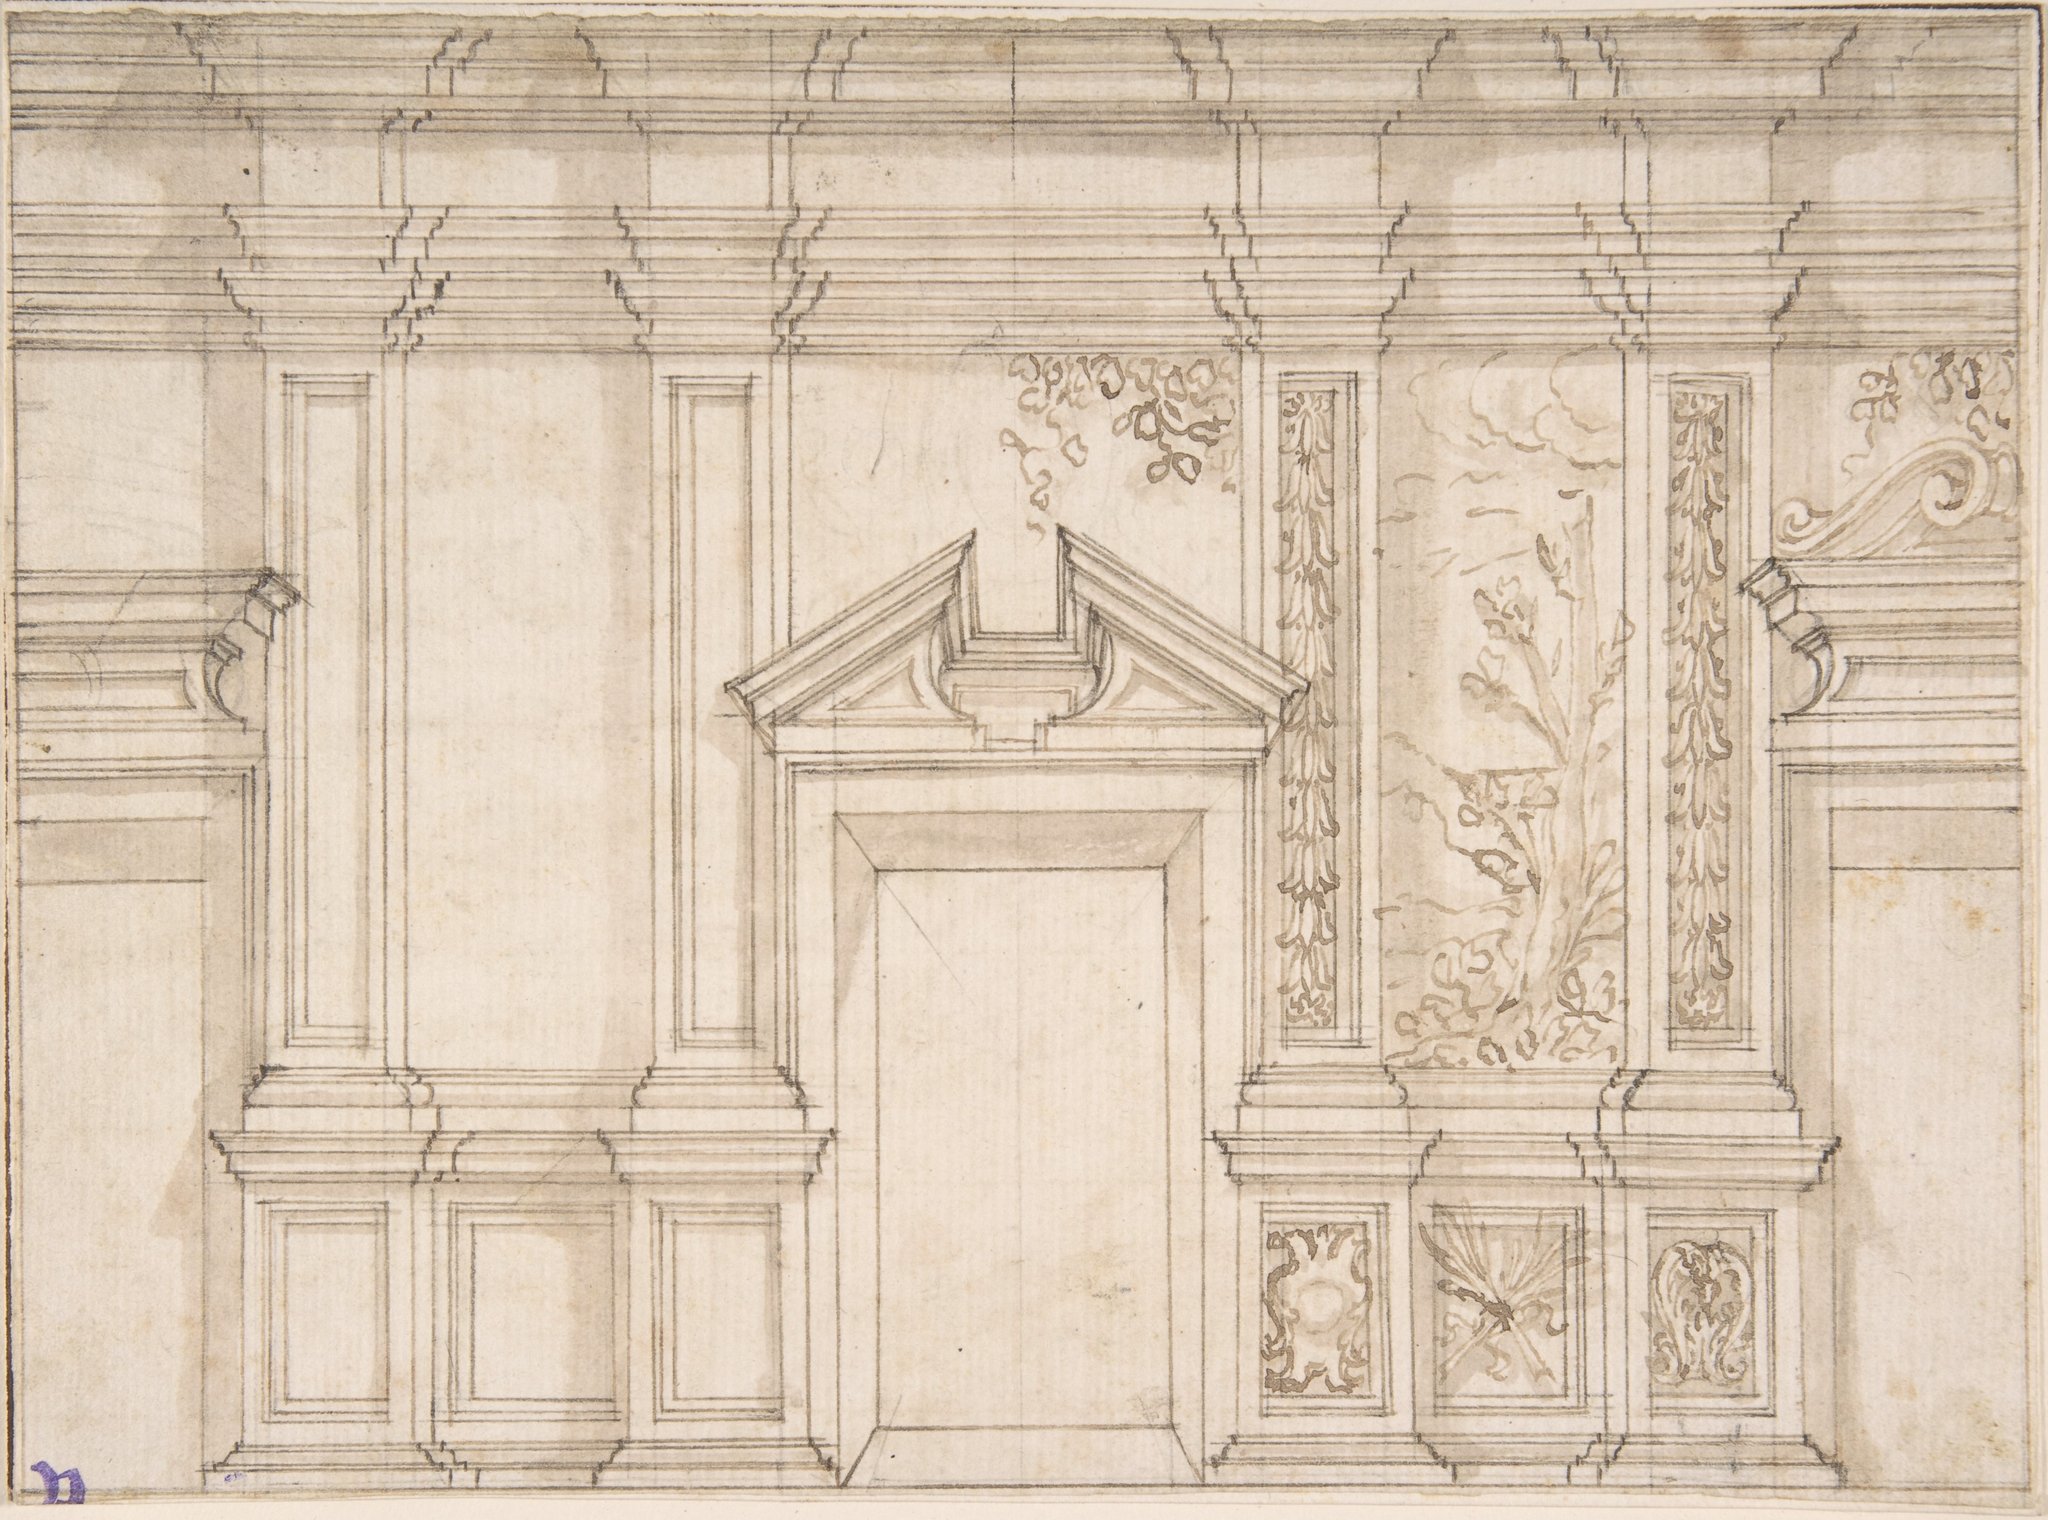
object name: drawing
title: Design for a Wall Elevation with Garlands and a Landcape Scene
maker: anonymous, italian, 17th century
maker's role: artist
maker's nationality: italian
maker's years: 1600-1700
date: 1601-1700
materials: graphite, ink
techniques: brush, pen, wash